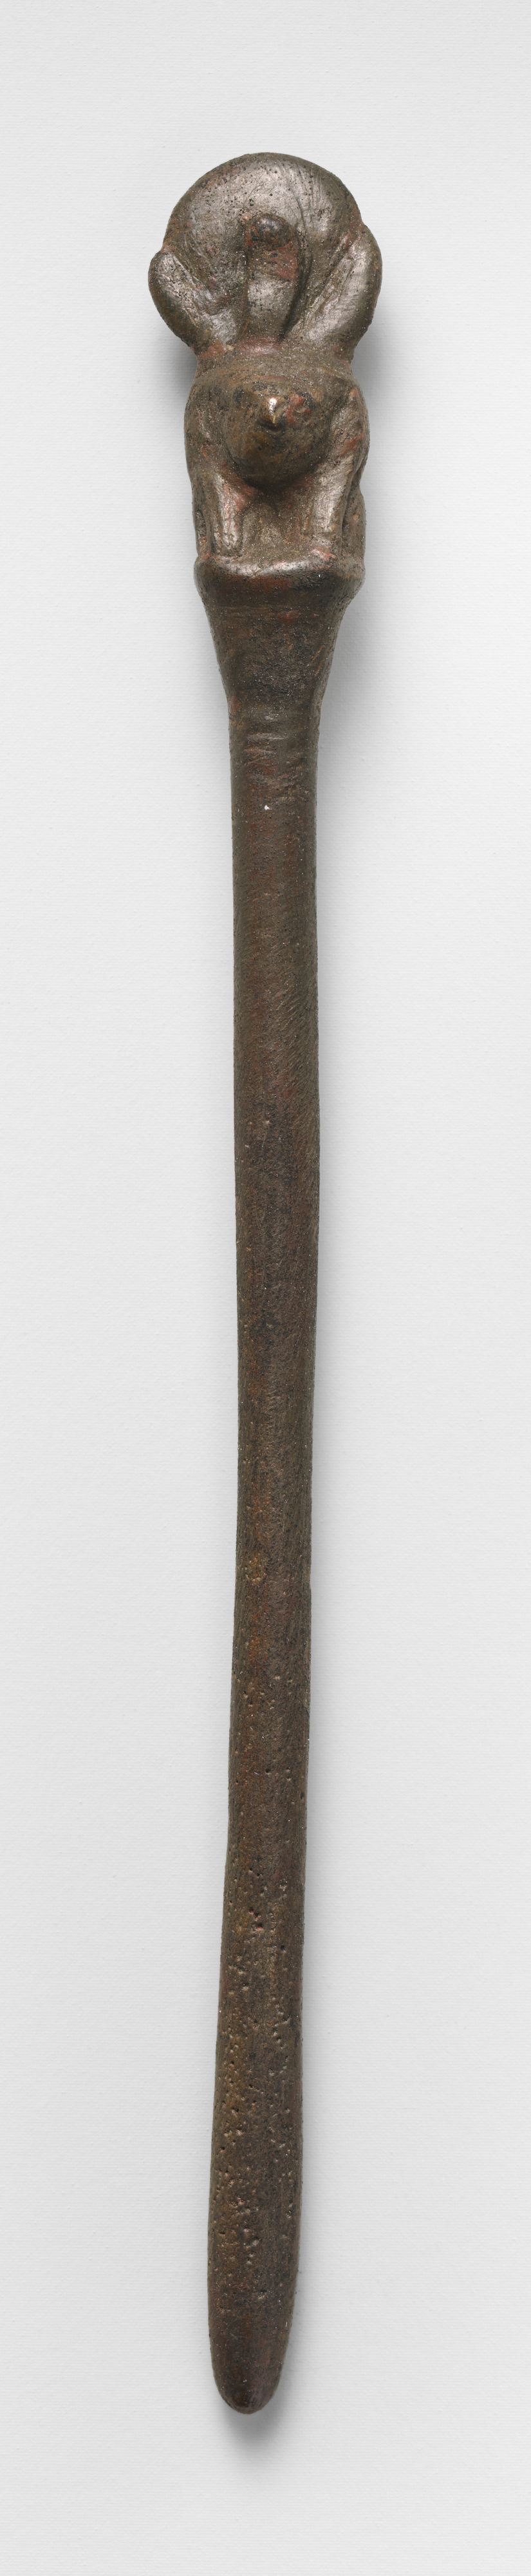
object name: scepter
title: Scepter with Montu head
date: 688-525 BCE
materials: copper alloy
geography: egypt